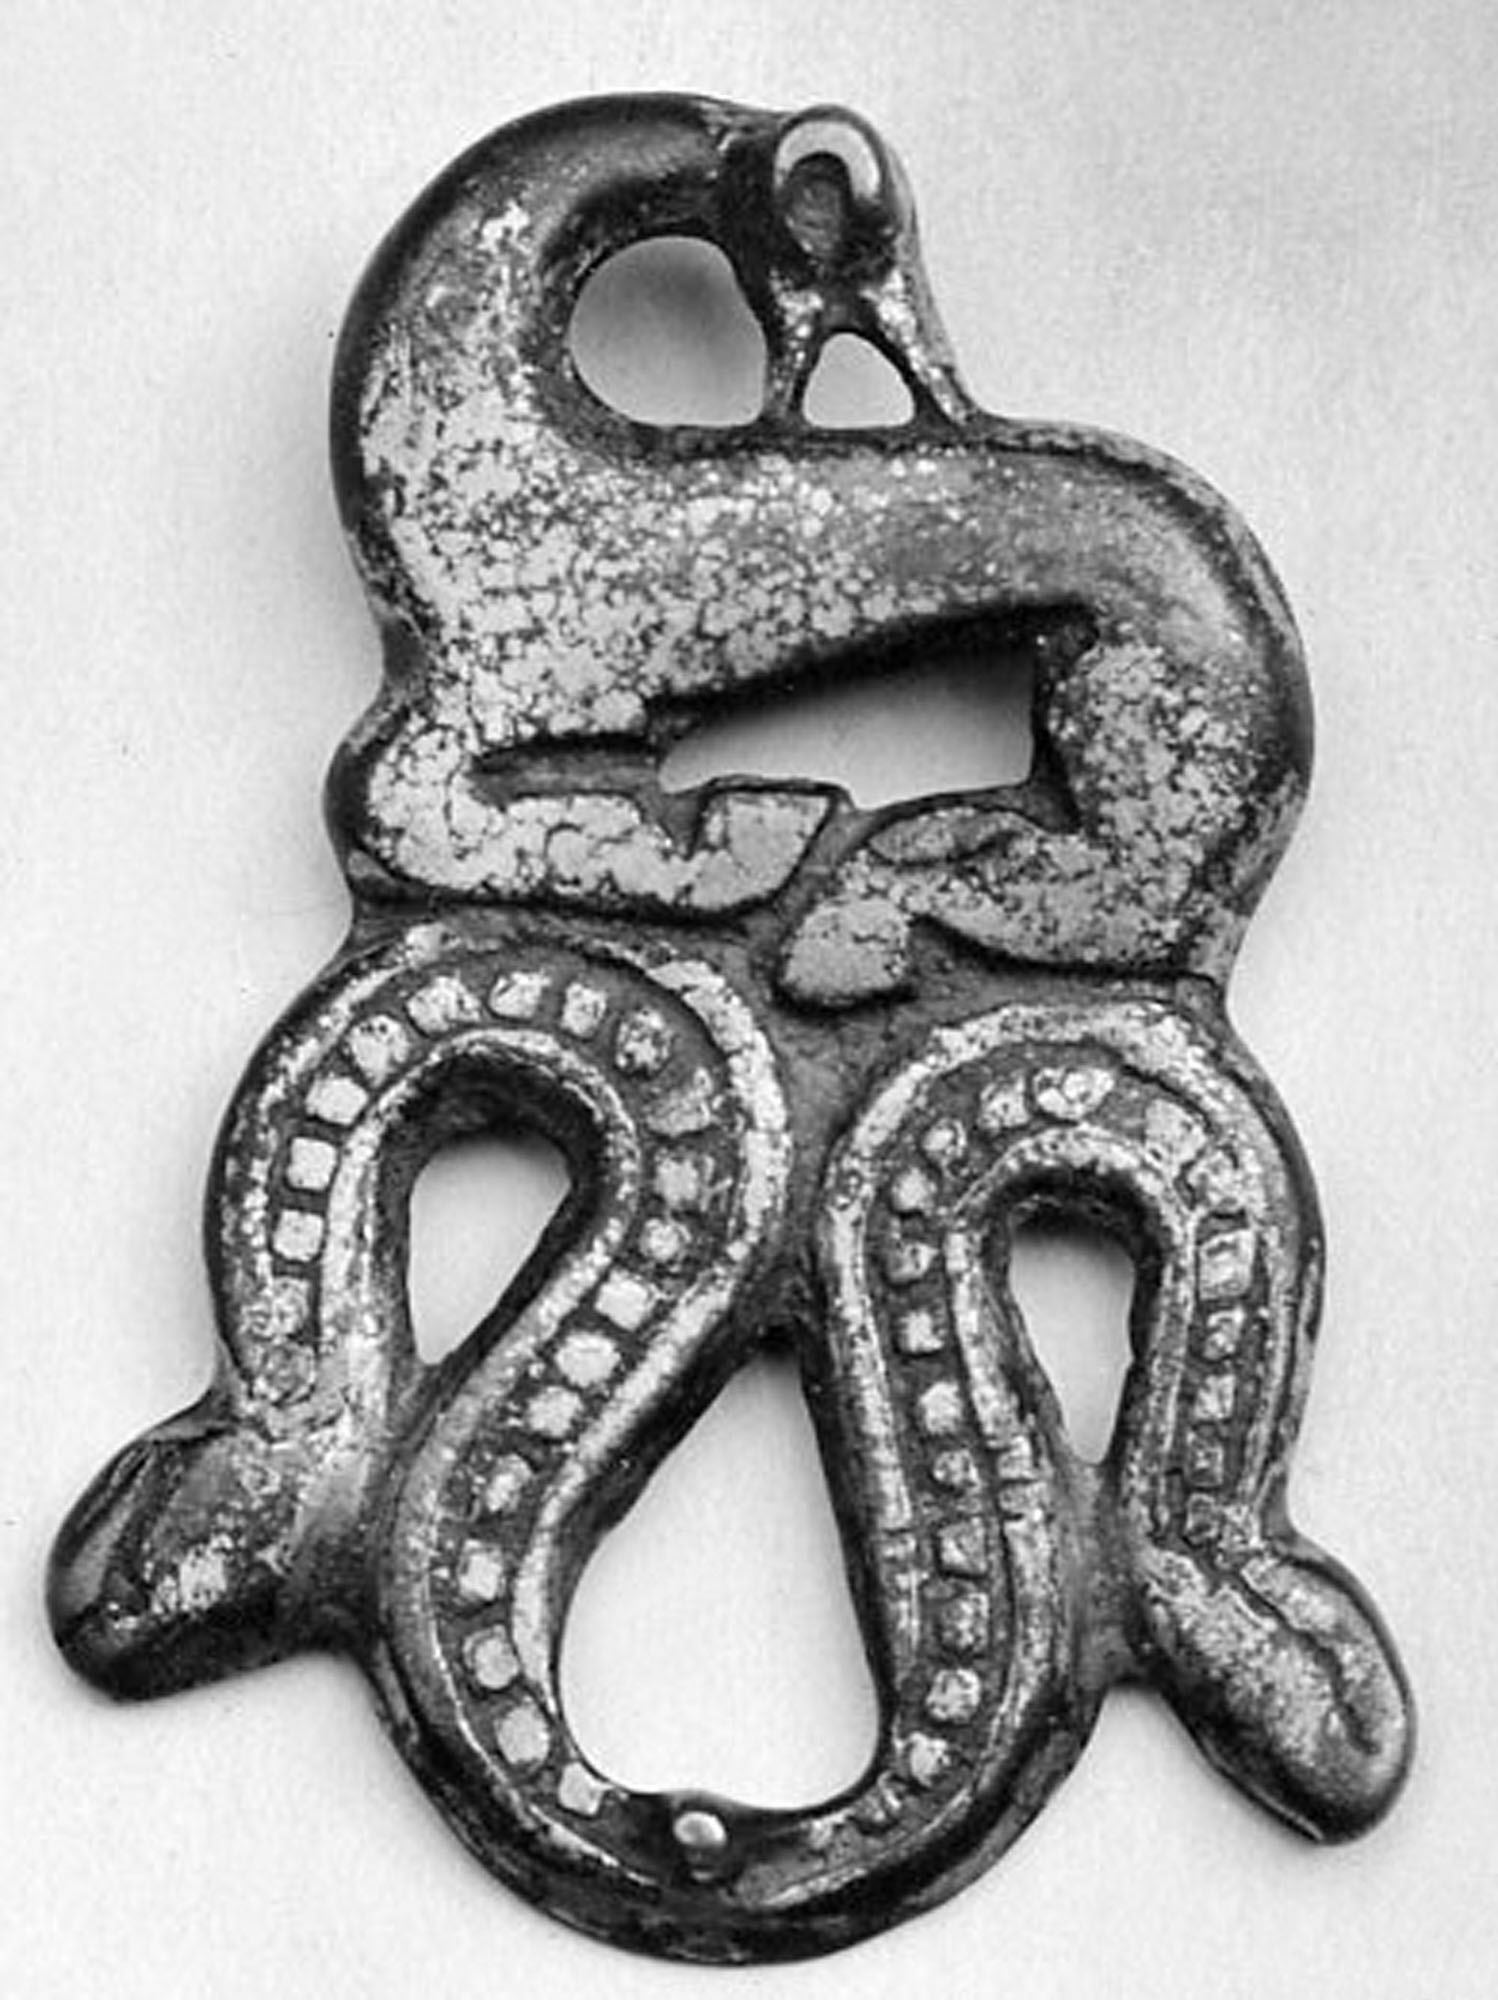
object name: buckle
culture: northern chinese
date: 500-201 BCE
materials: bronze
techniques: silvered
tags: animals,snakes